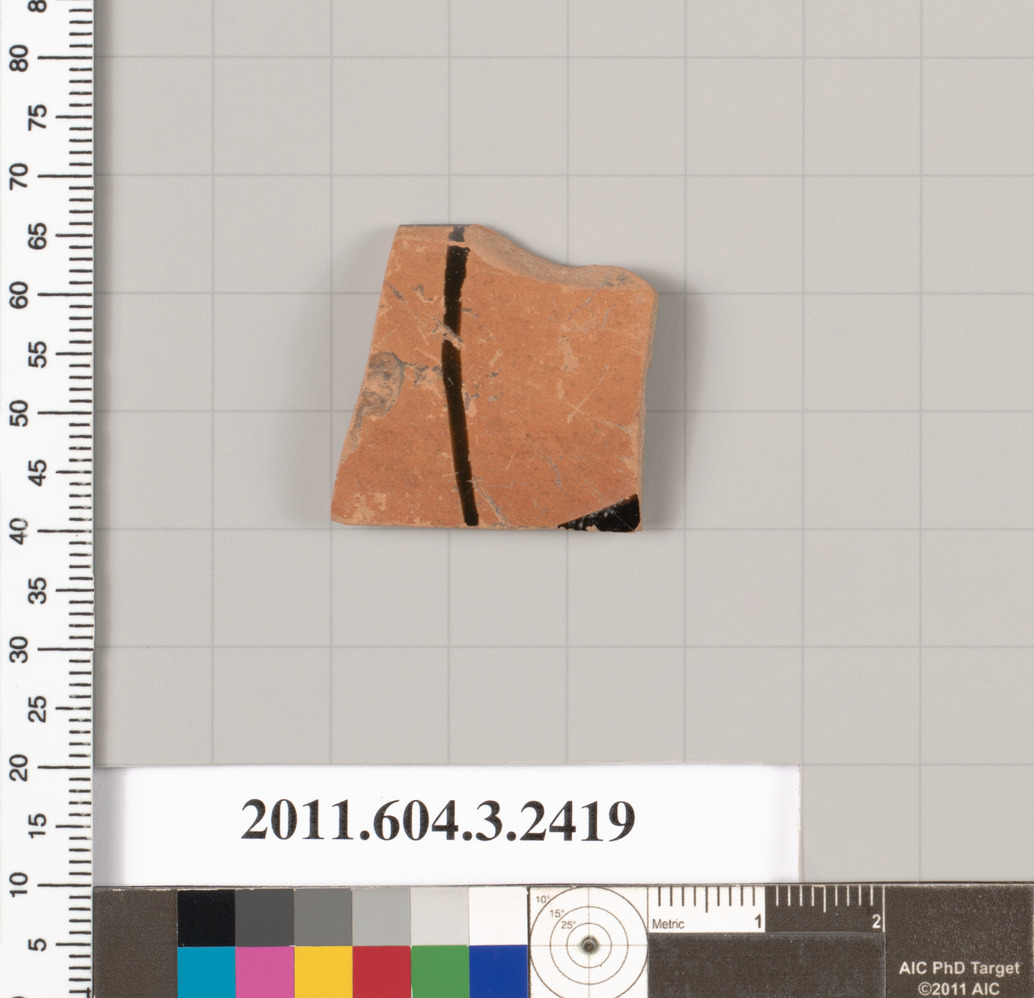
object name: kylix fragment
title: Terracotta rim fragment of a kylix: eye-cup (drinking cup)?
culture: greek, attic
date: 530-510 BCE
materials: terracotta